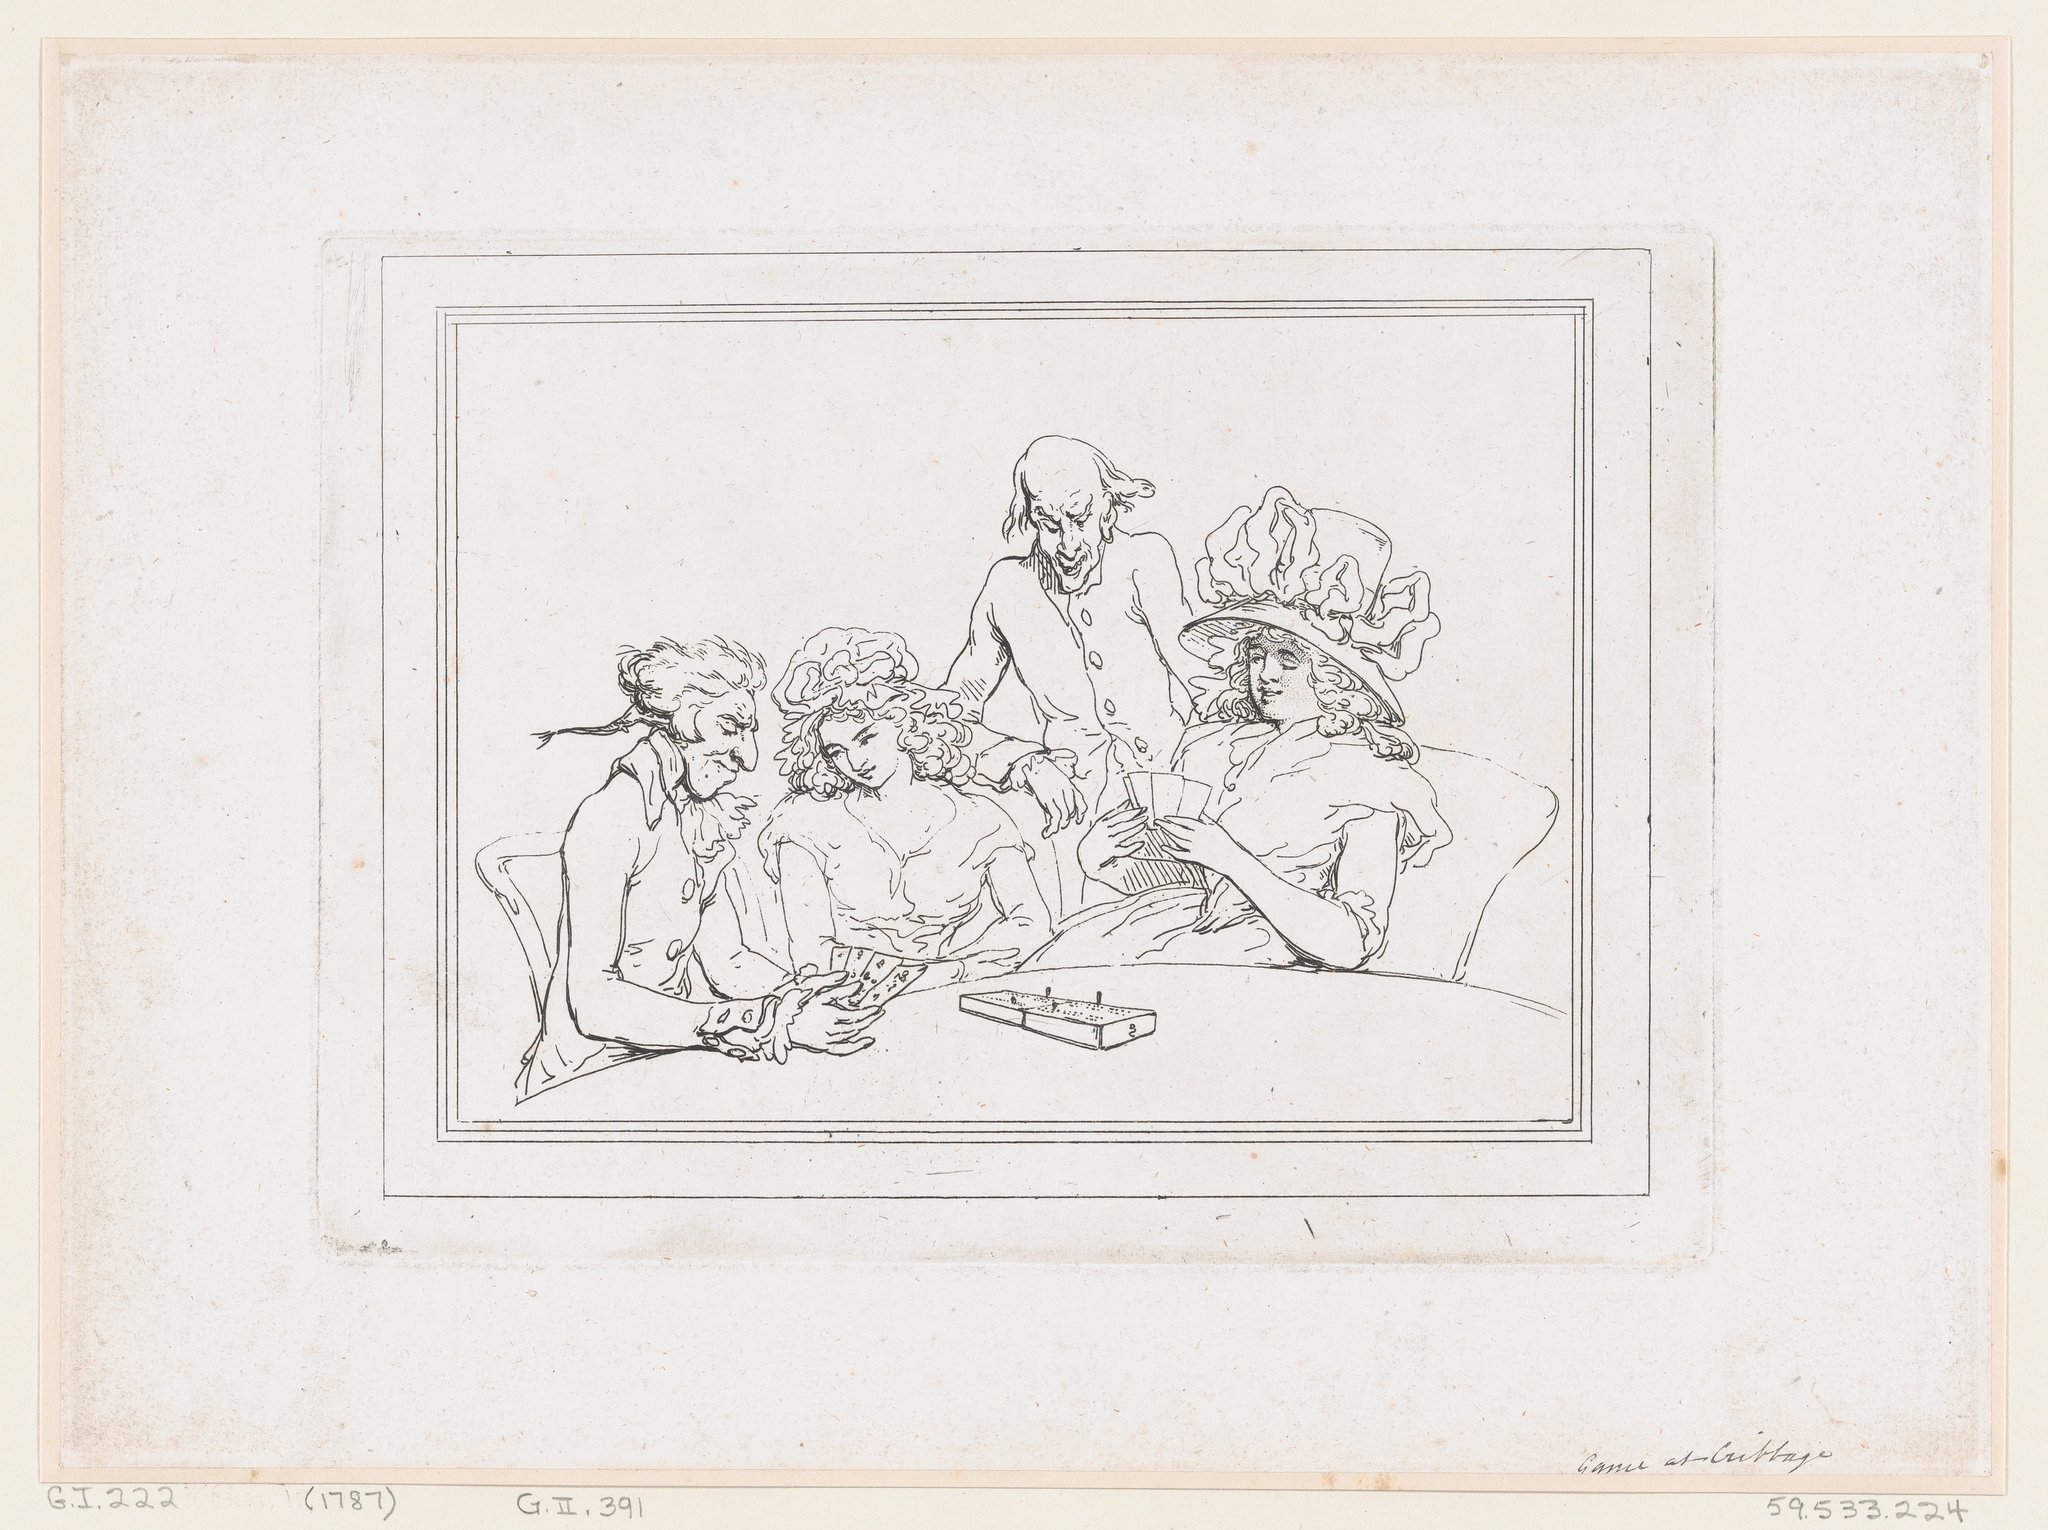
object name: print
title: Game at Cribbage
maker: thomas rowlandson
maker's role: artist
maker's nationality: british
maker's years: 1757-1827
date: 1787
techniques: etching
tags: men,women,playing cards